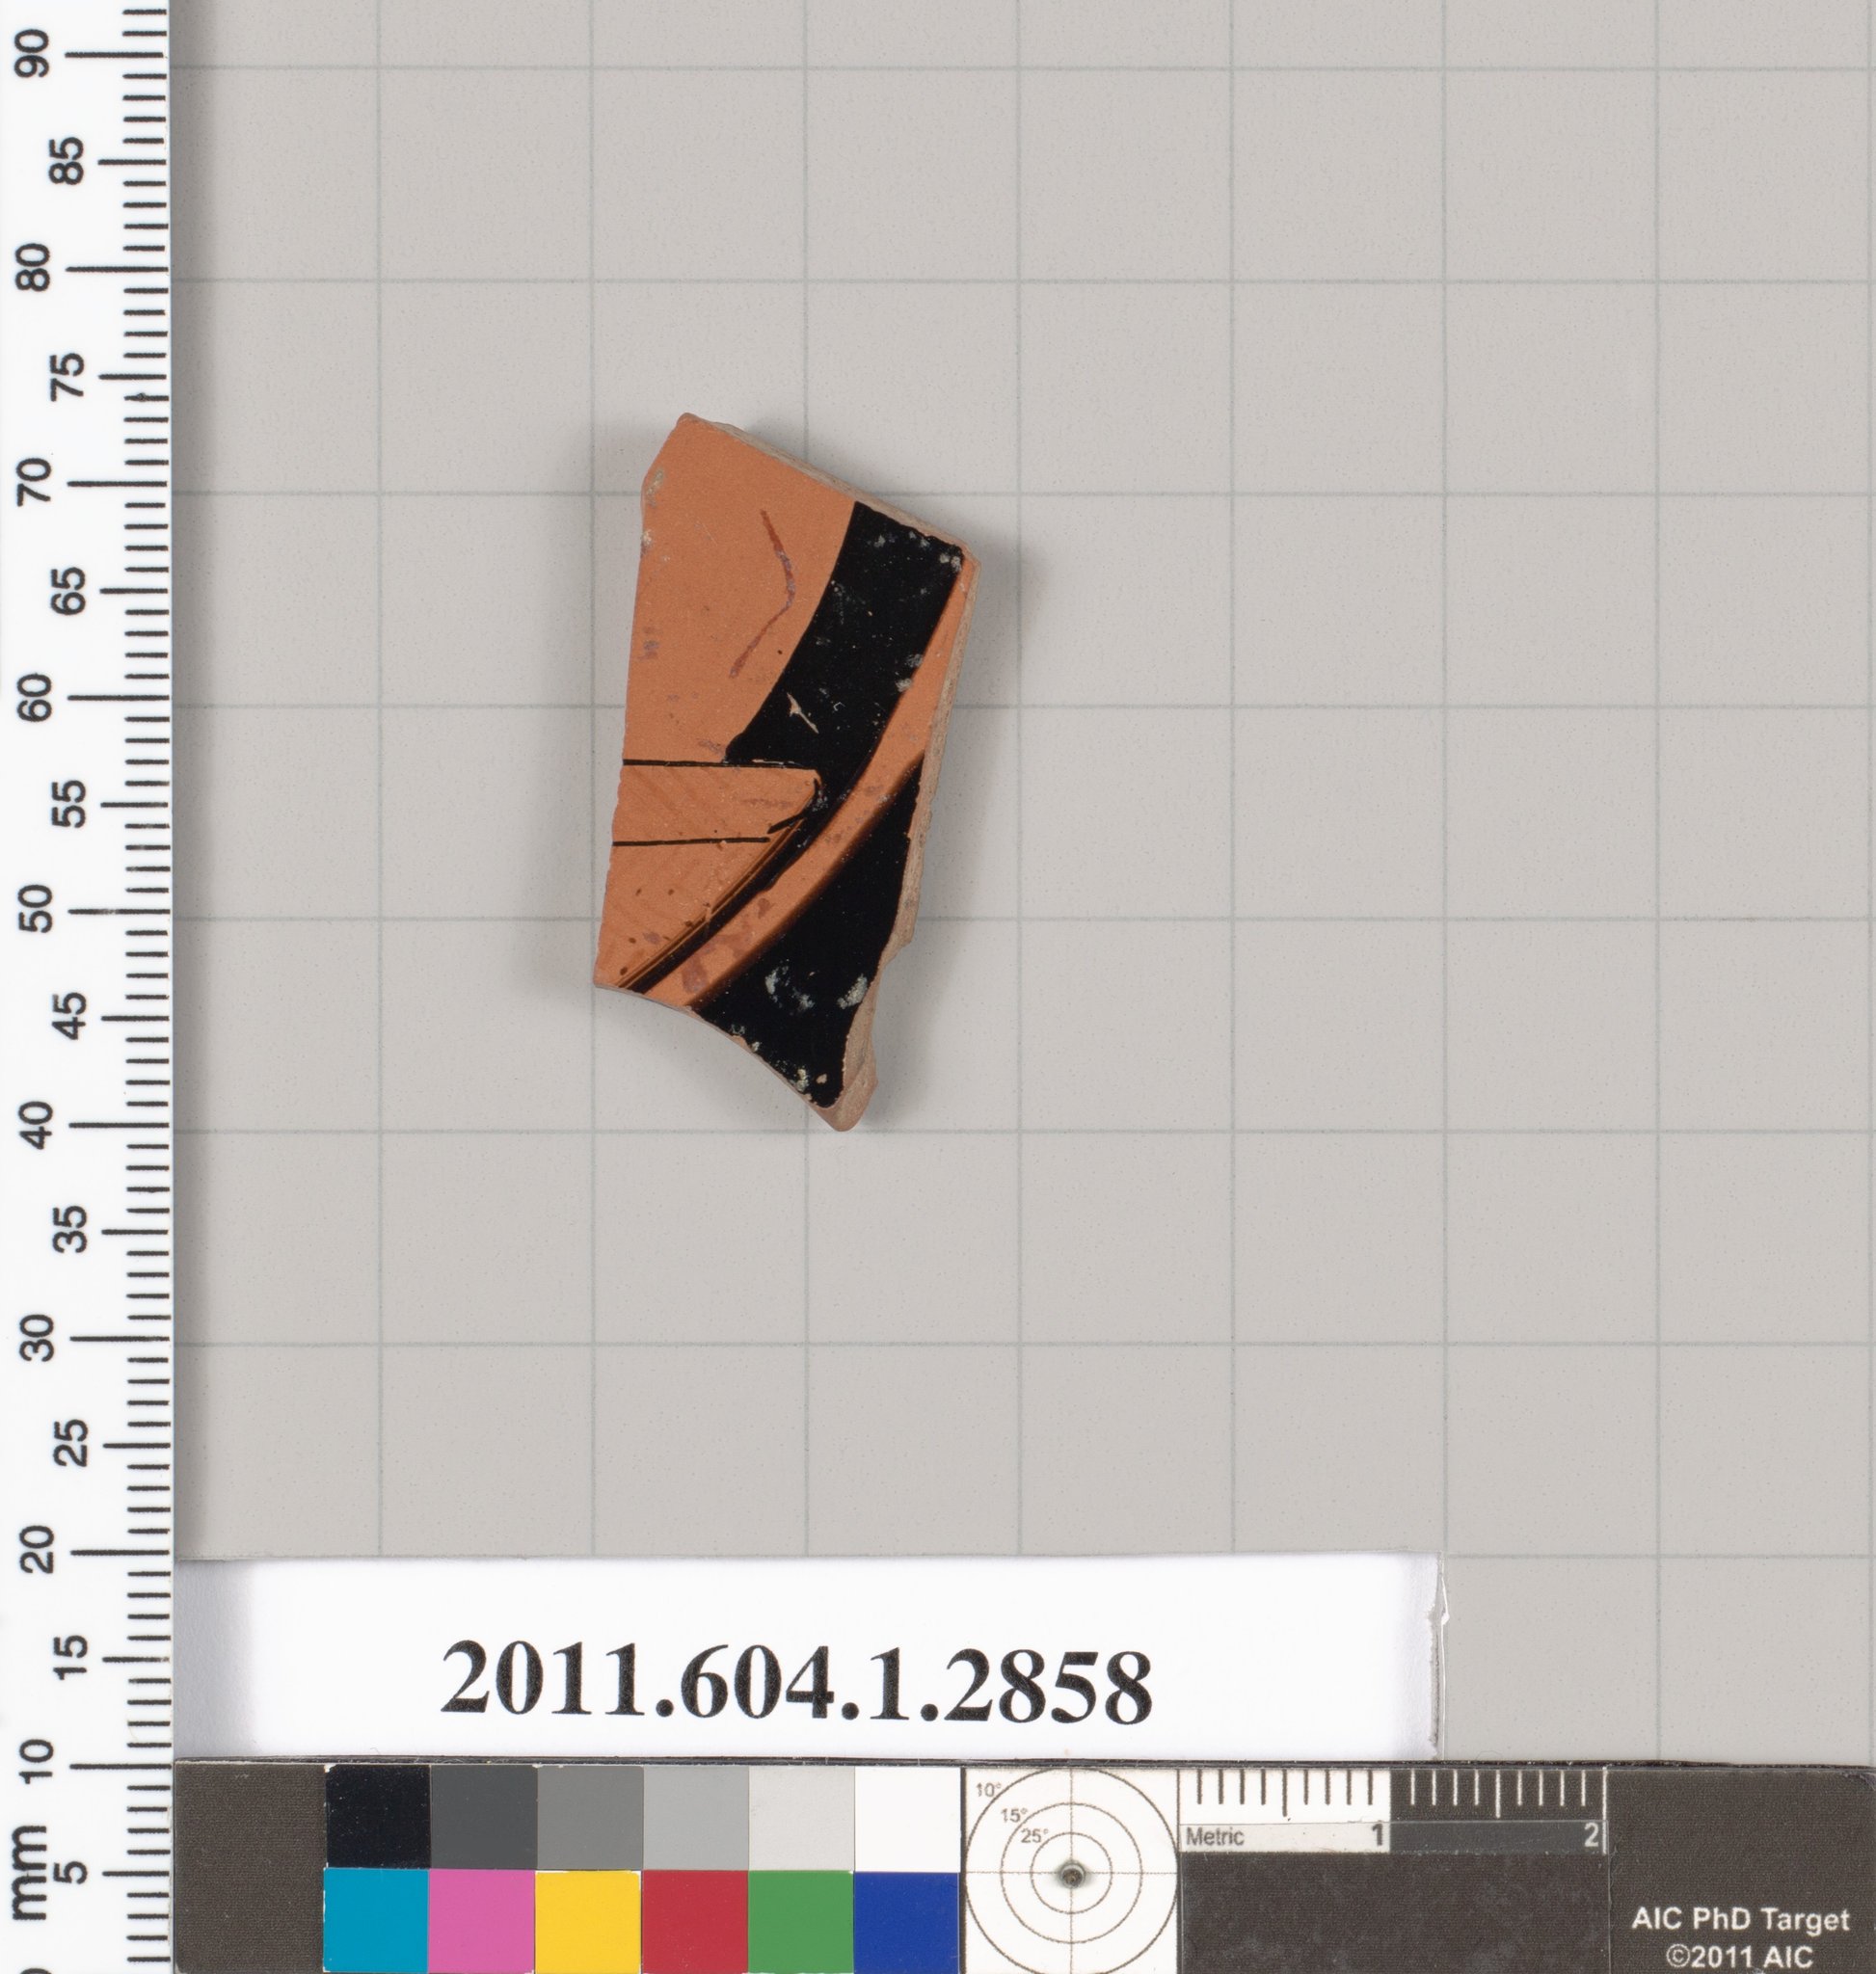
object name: kylix fragment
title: Terracotta fragment of a kylix (drinking cup)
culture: greek, attic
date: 500-476 BCE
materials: terracotta